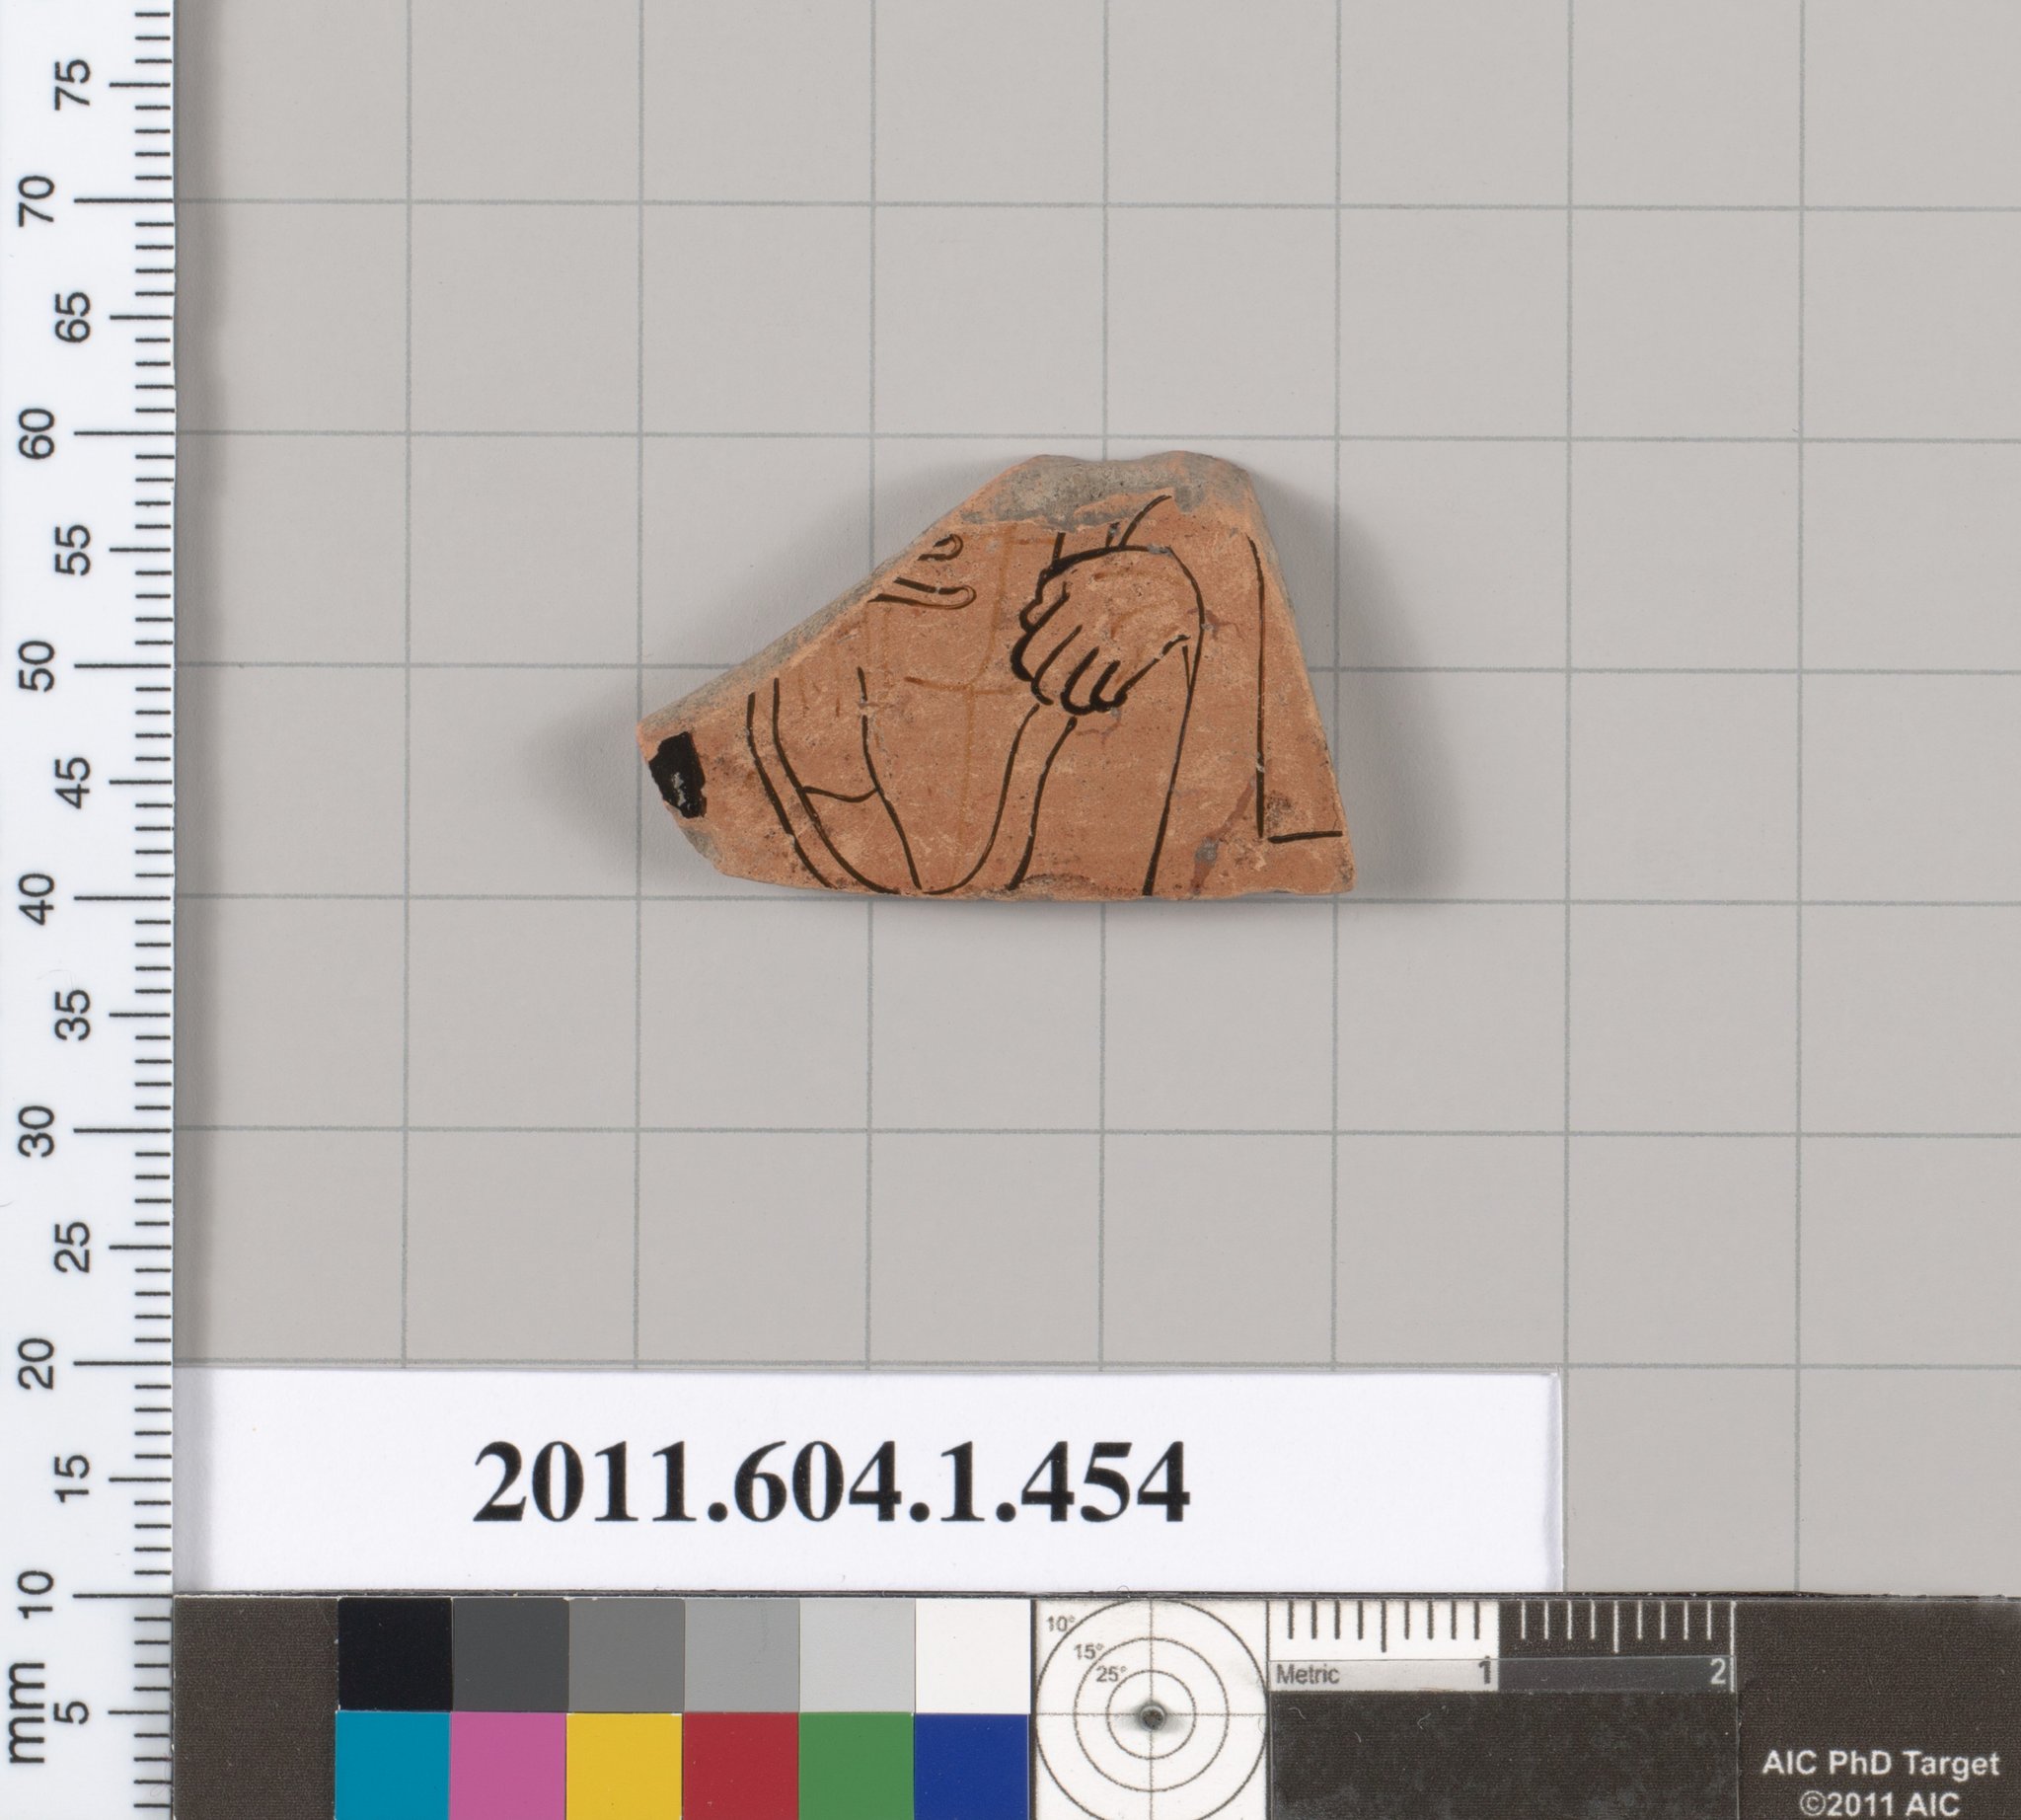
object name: kylix fragment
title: Terracotta fragment of a kylix (drinking cup)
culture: greek, attic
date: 475-451 BCE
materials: terracotta